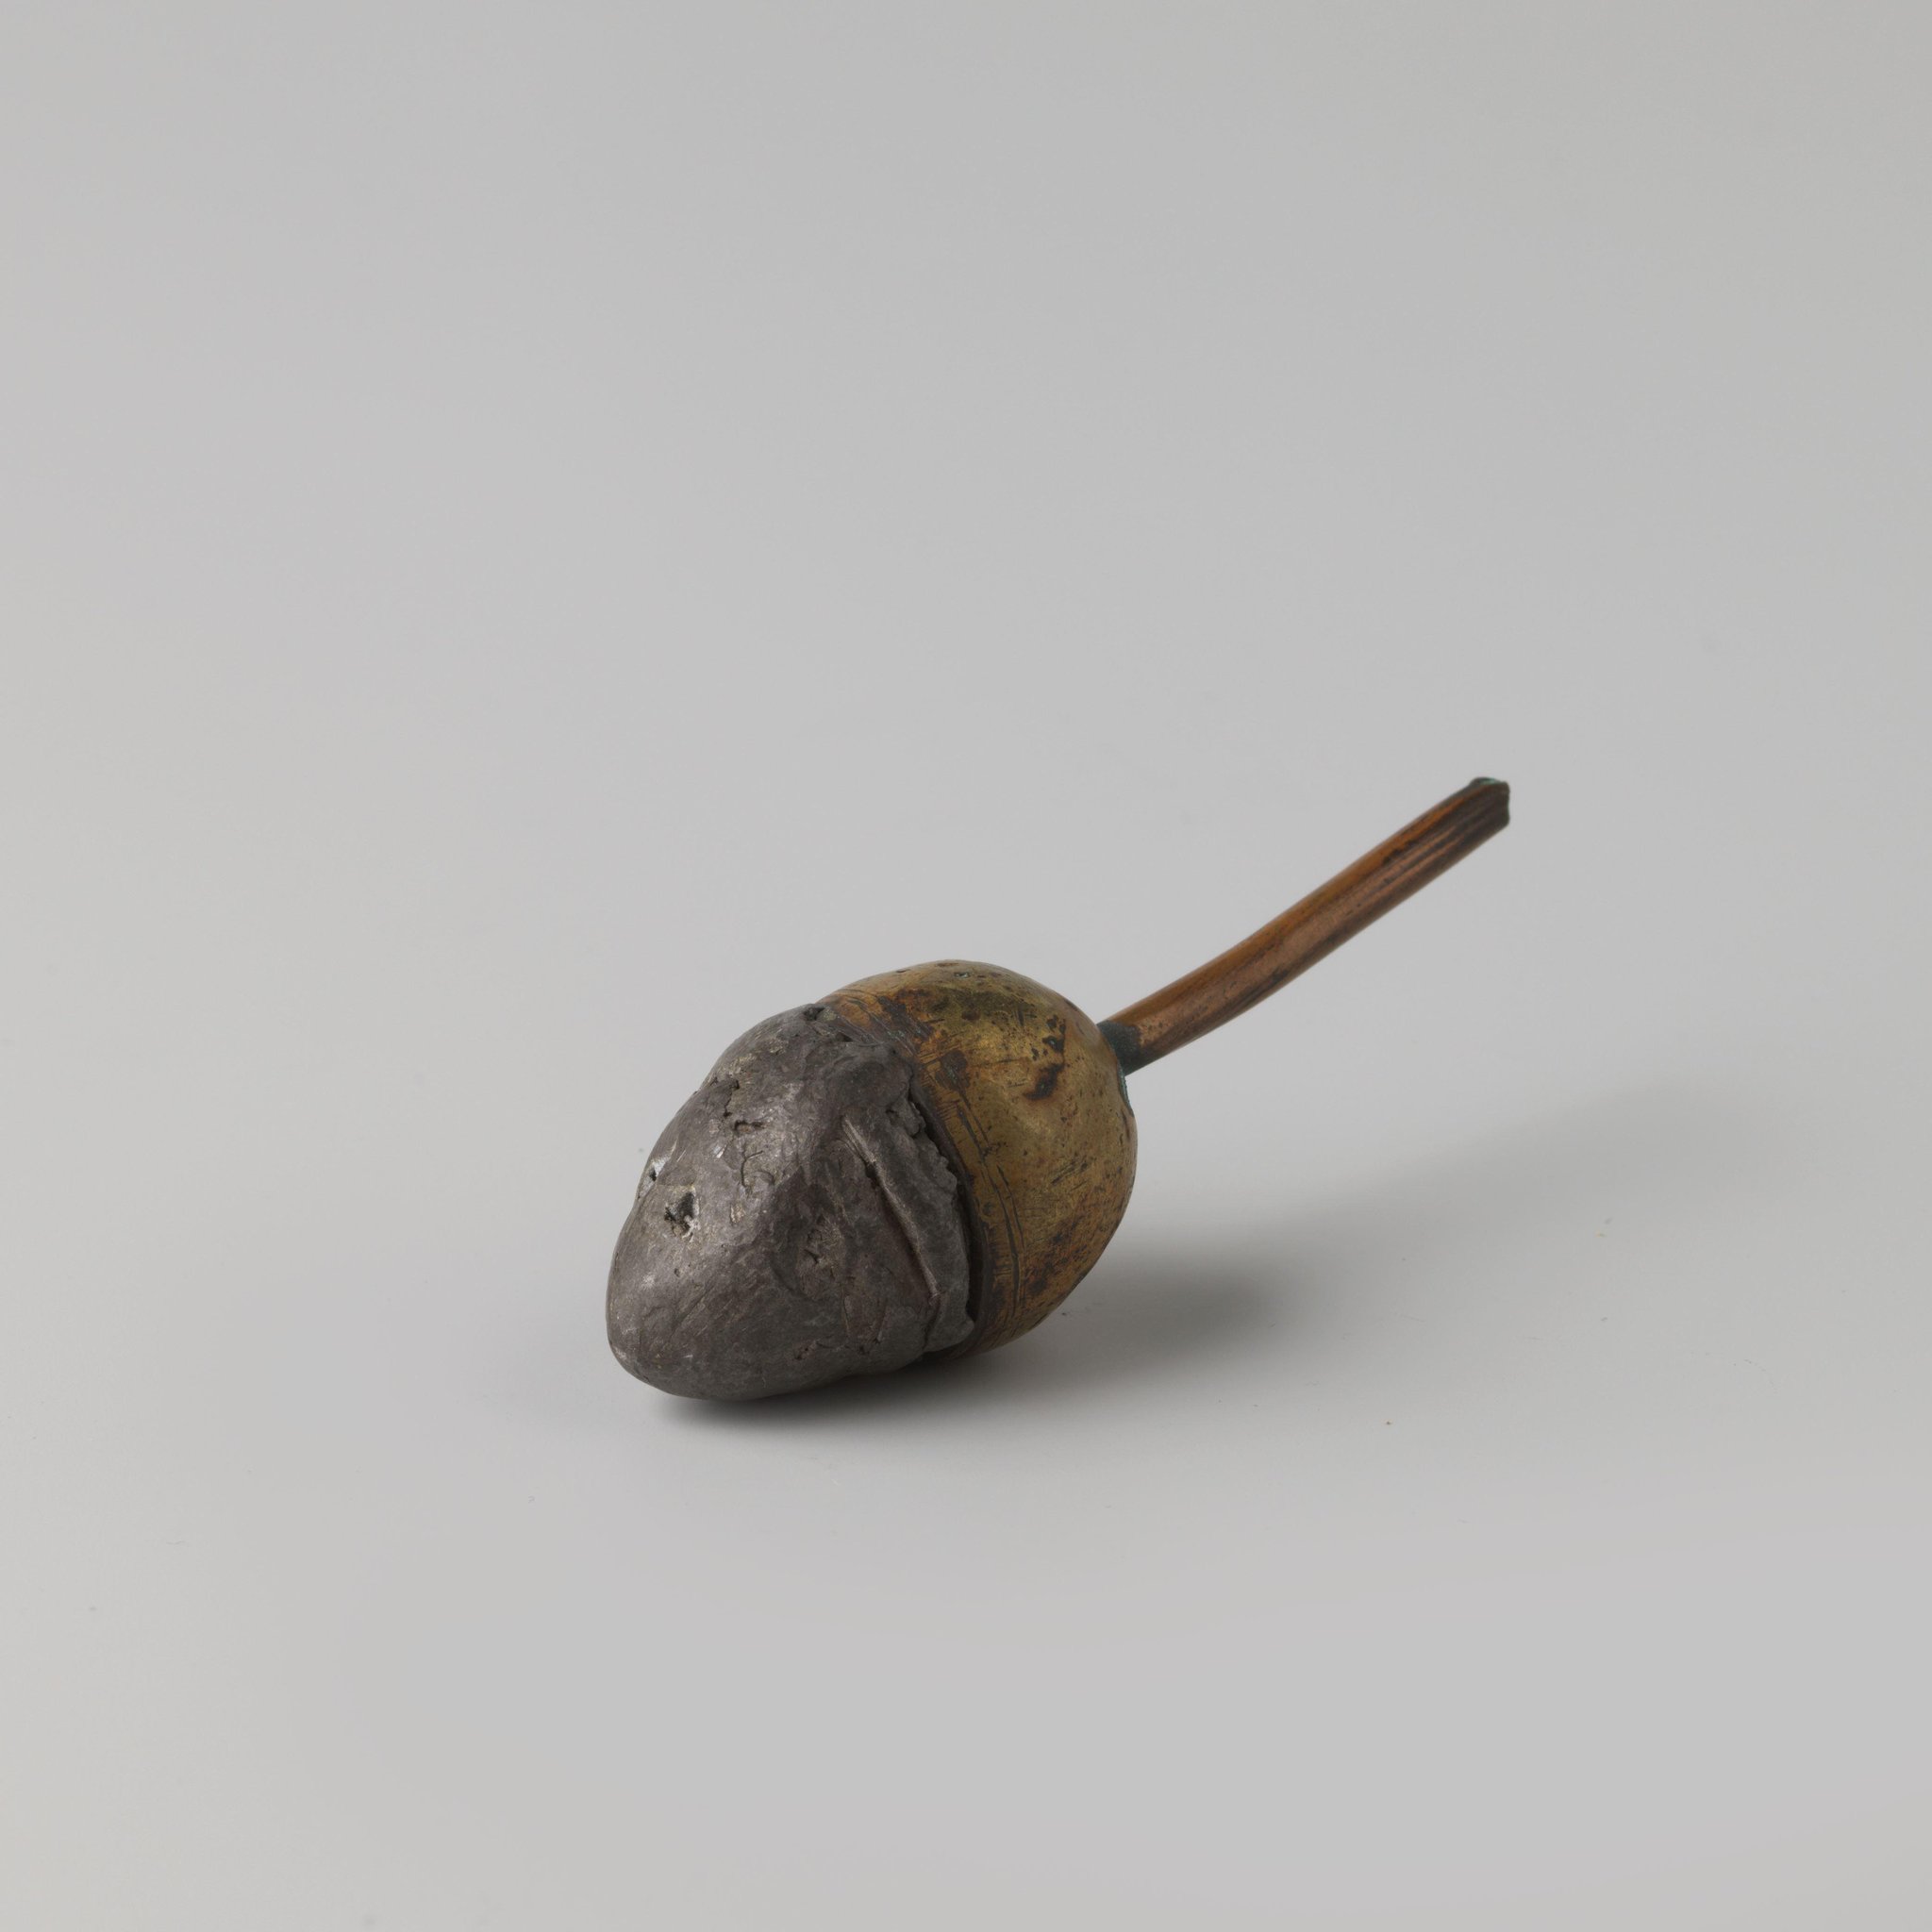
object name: acorn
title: Steeltje van de Stichting Diamantbewerkers Koperen Stelen Fonds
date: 1905-1960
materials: copper, lead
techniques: forging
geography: amsterdam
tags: de stichting diamantbewerkers koperen stelen fonds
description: Eikel, het steeltje gemaakt van rood koper, het dopje van geel koper, de eikel zelf van een ruw klompje lood. De Stichting Diamantbewerkers Koperen Stelen Fonds (opgericht in 1905) had als doel de verpleging en herstel van georganiseerde diamantbewerkers mogelijk te maken in herstellingsoorden en santoria. Koperen steeltjes dienden als gereedschap bij het diamantslijpen. Afgebroken steeltjes konden te gelde worden gemaakt.